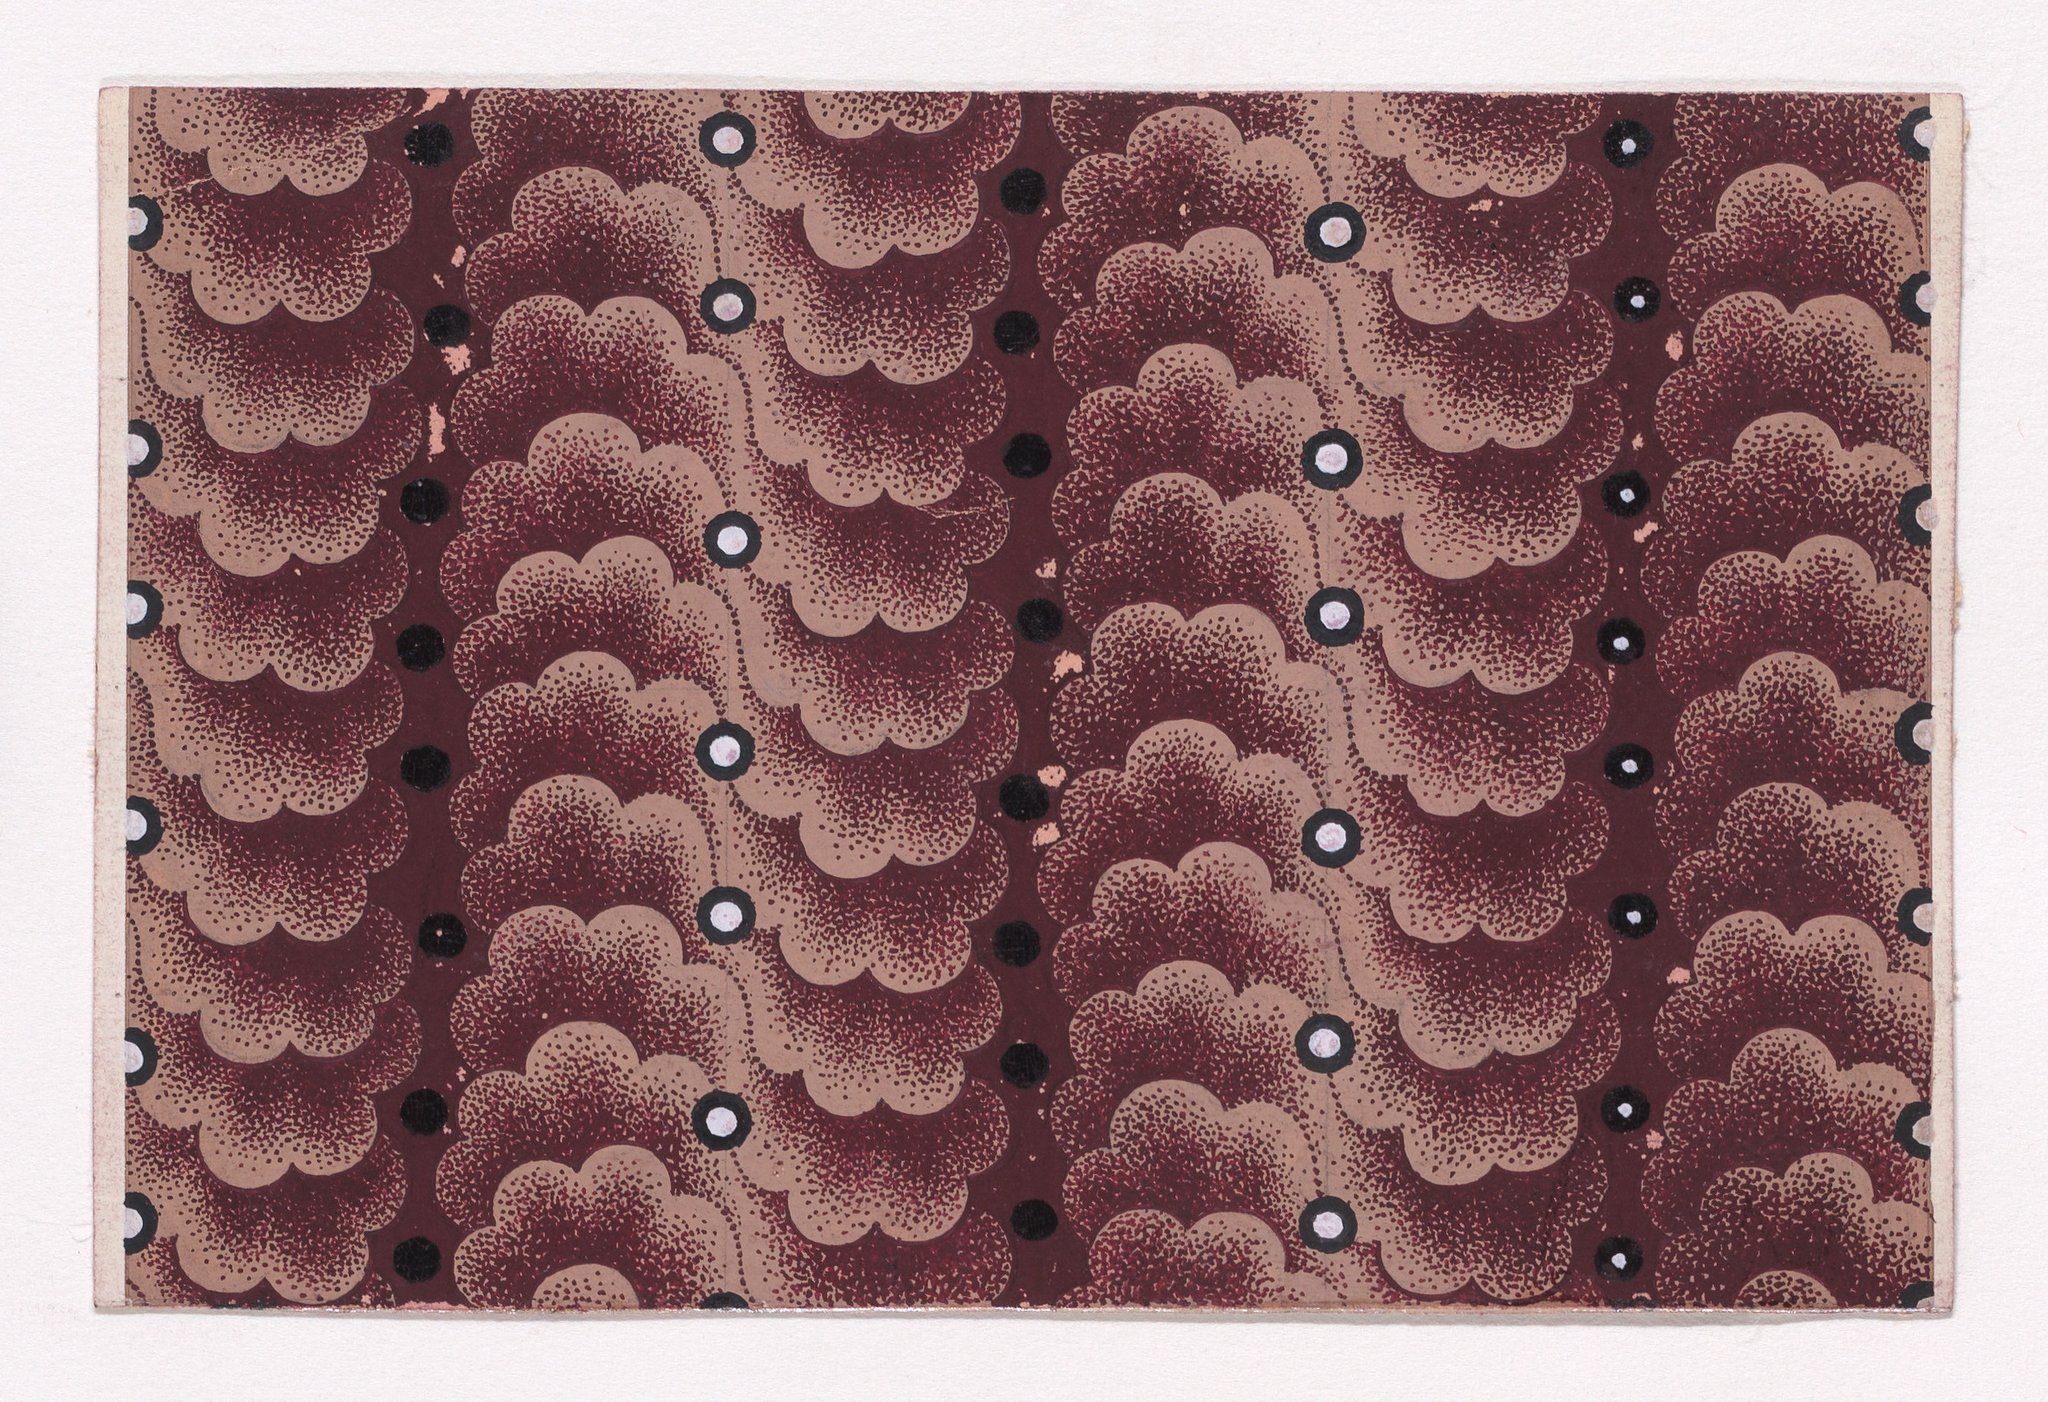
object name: drawing ornament architecture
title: Textile Design with Vertical Strips of Clouds and Circles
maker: anonymous, alsatian, 19th century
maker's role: artist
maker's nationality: alsatian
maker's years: 1800-1900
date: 1840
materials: gouache